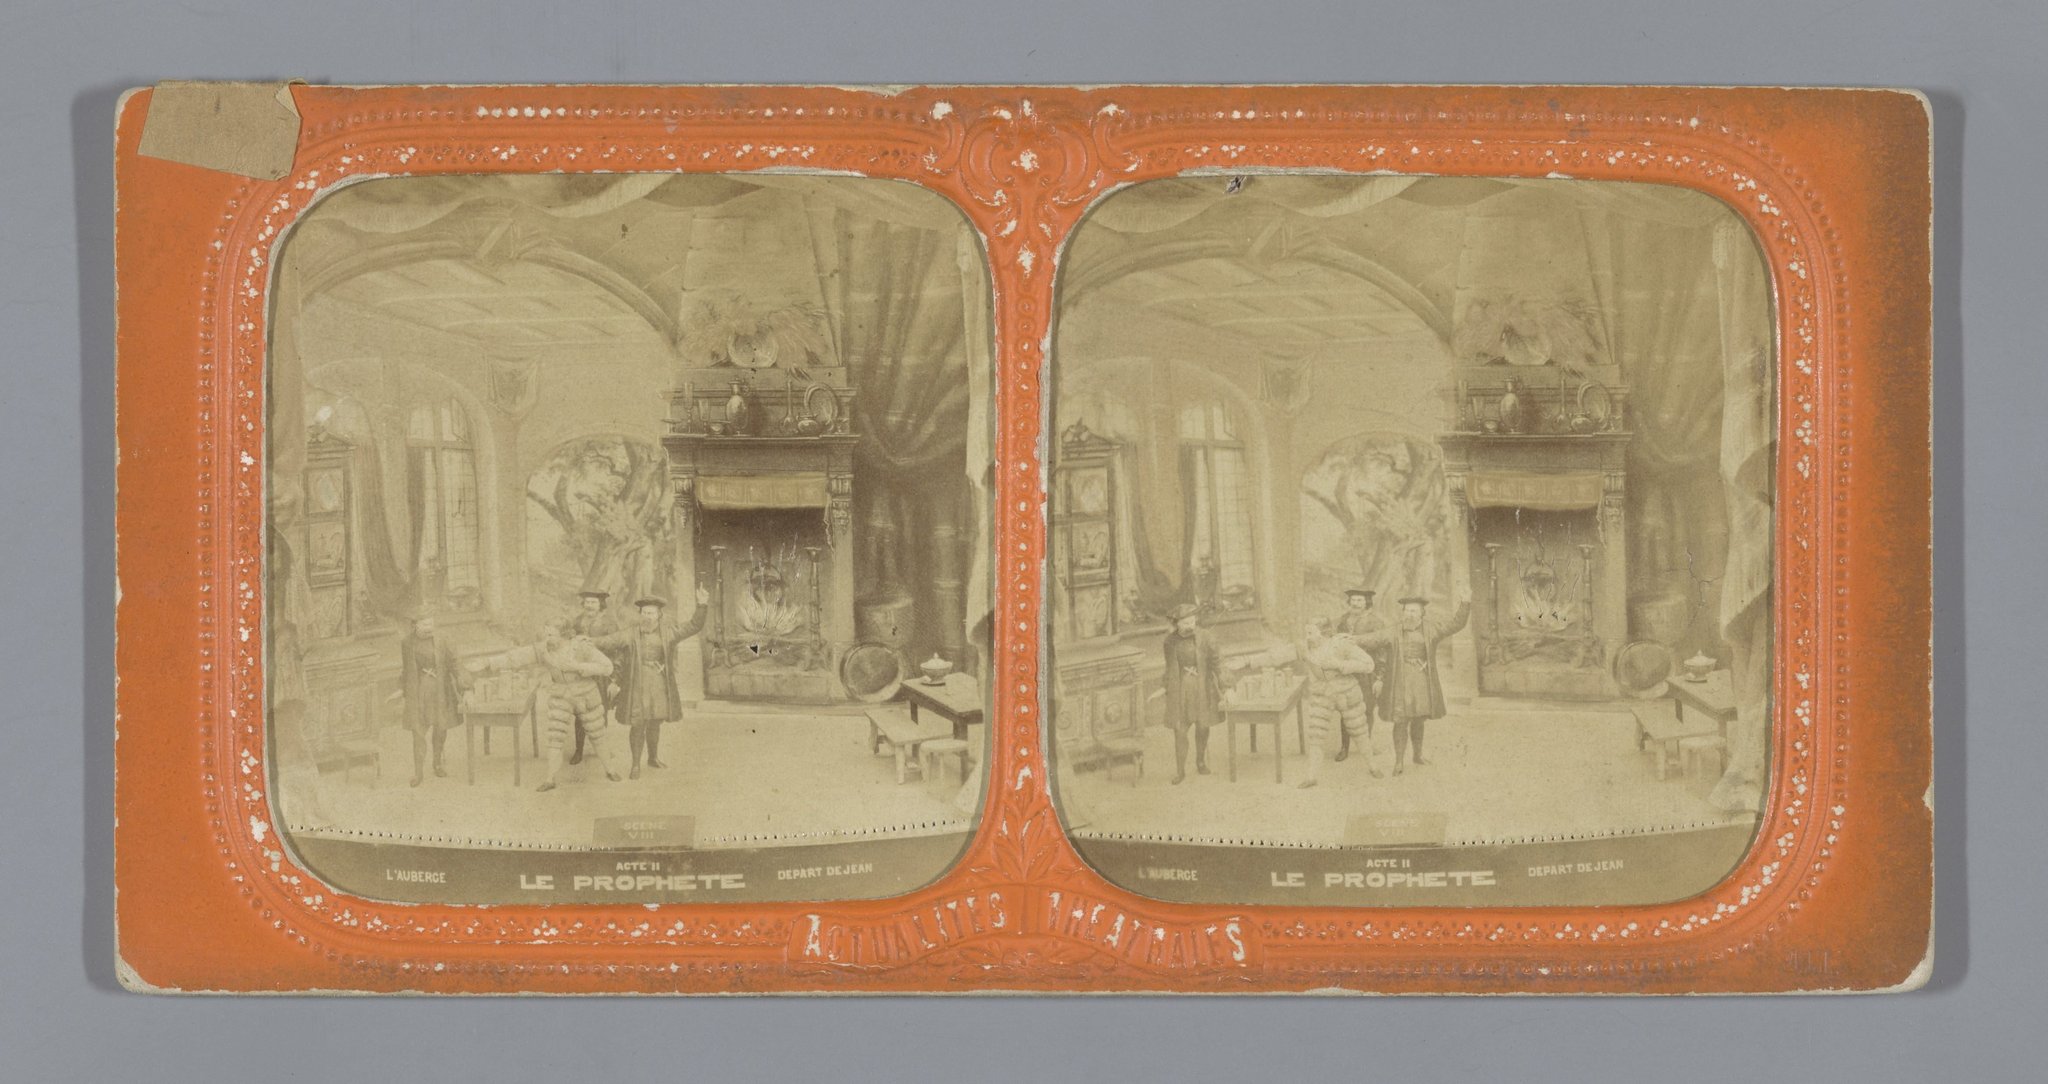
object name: tissue stereograph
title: Tweede bedrijf, achtste scène van Le Prophète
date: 1866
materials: cardboard, paper, photographic support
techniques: albumen print, hand coloring, perforating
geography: paris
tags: opera